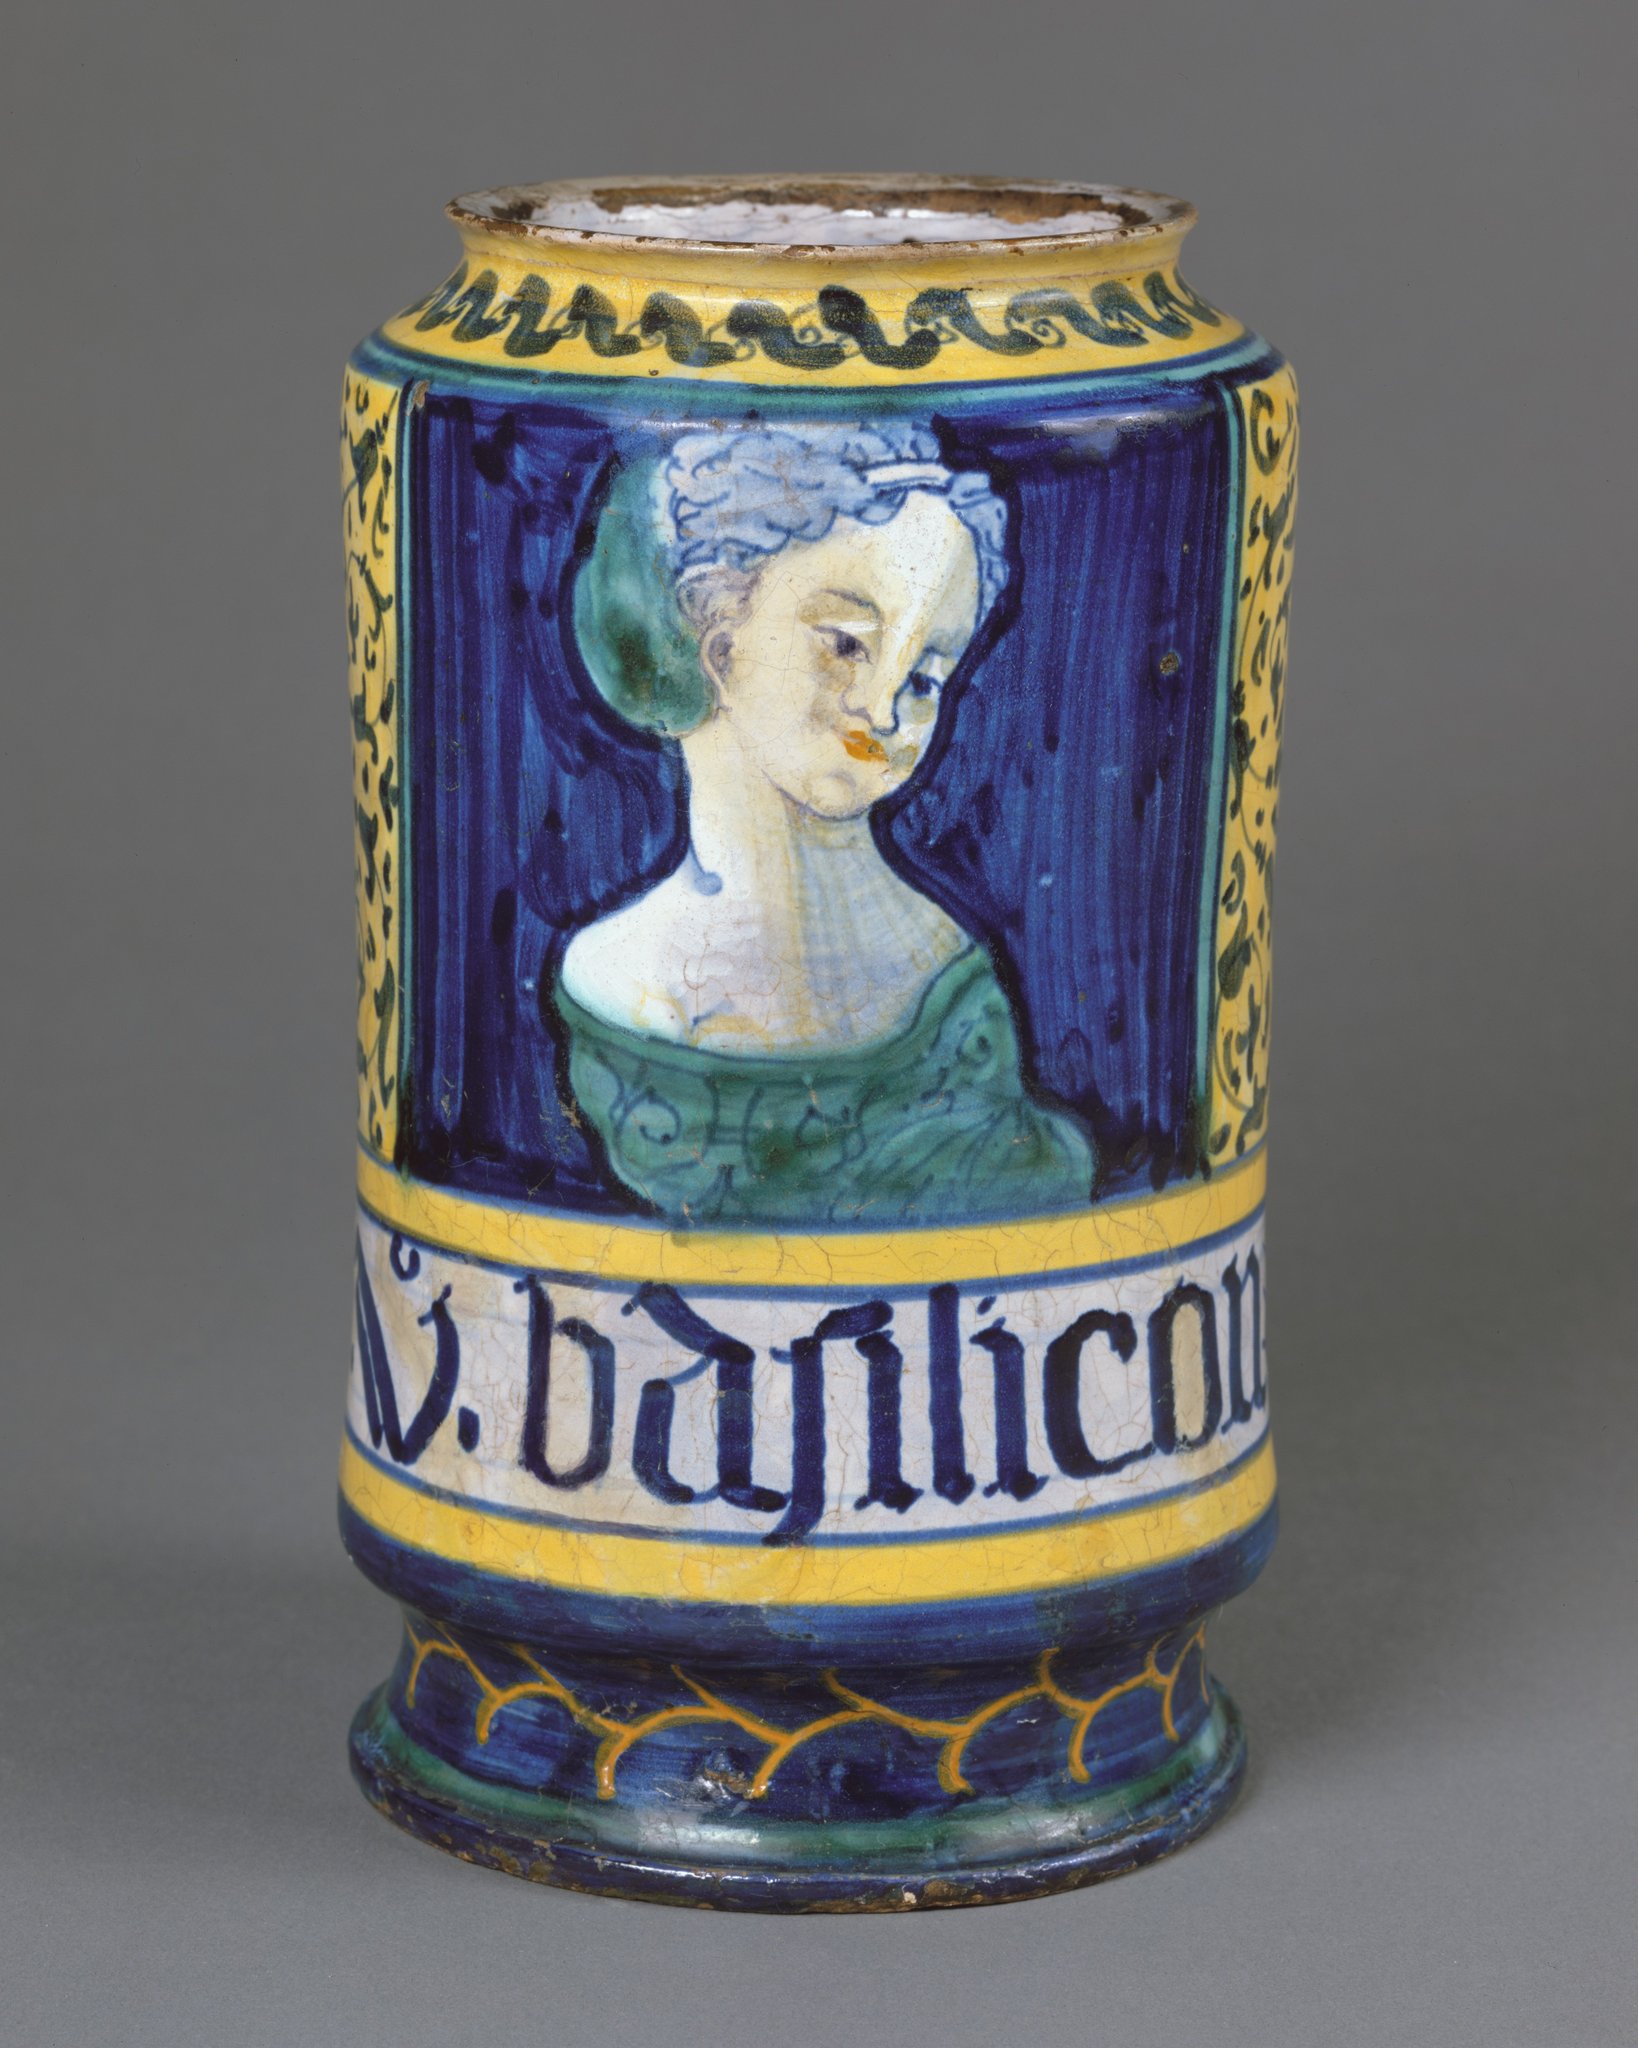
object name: albarello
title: Apothecary jar (albarello)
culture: italian, castelli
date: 1530-1540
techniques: maiolica, glazing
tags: women